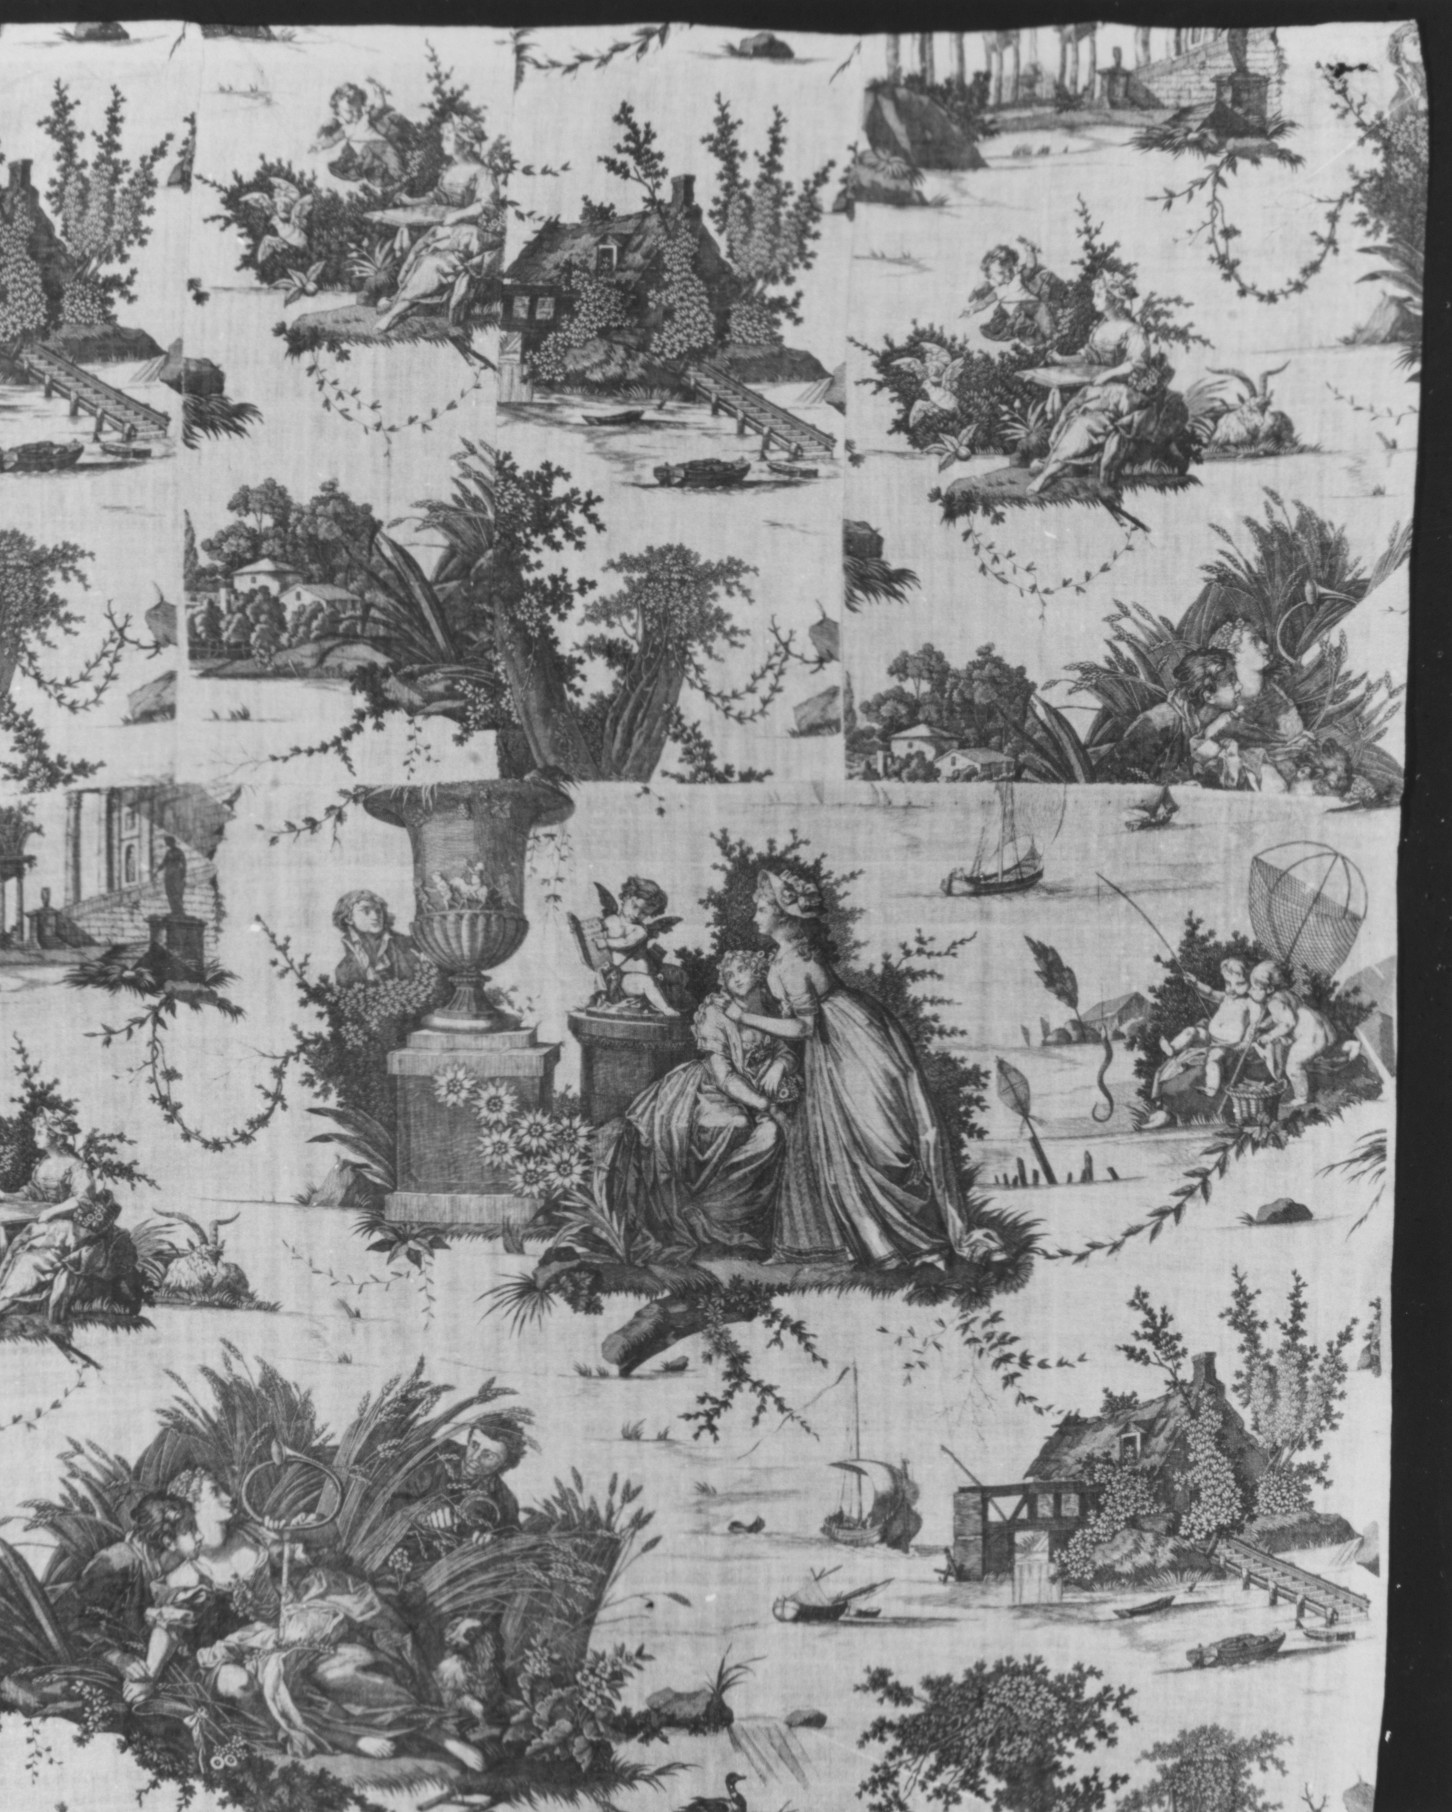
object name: piece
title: "L'Art d'Aimer"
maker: j.p. meillier et cie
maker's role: manufactory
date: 1792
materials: cotton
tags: women,putti